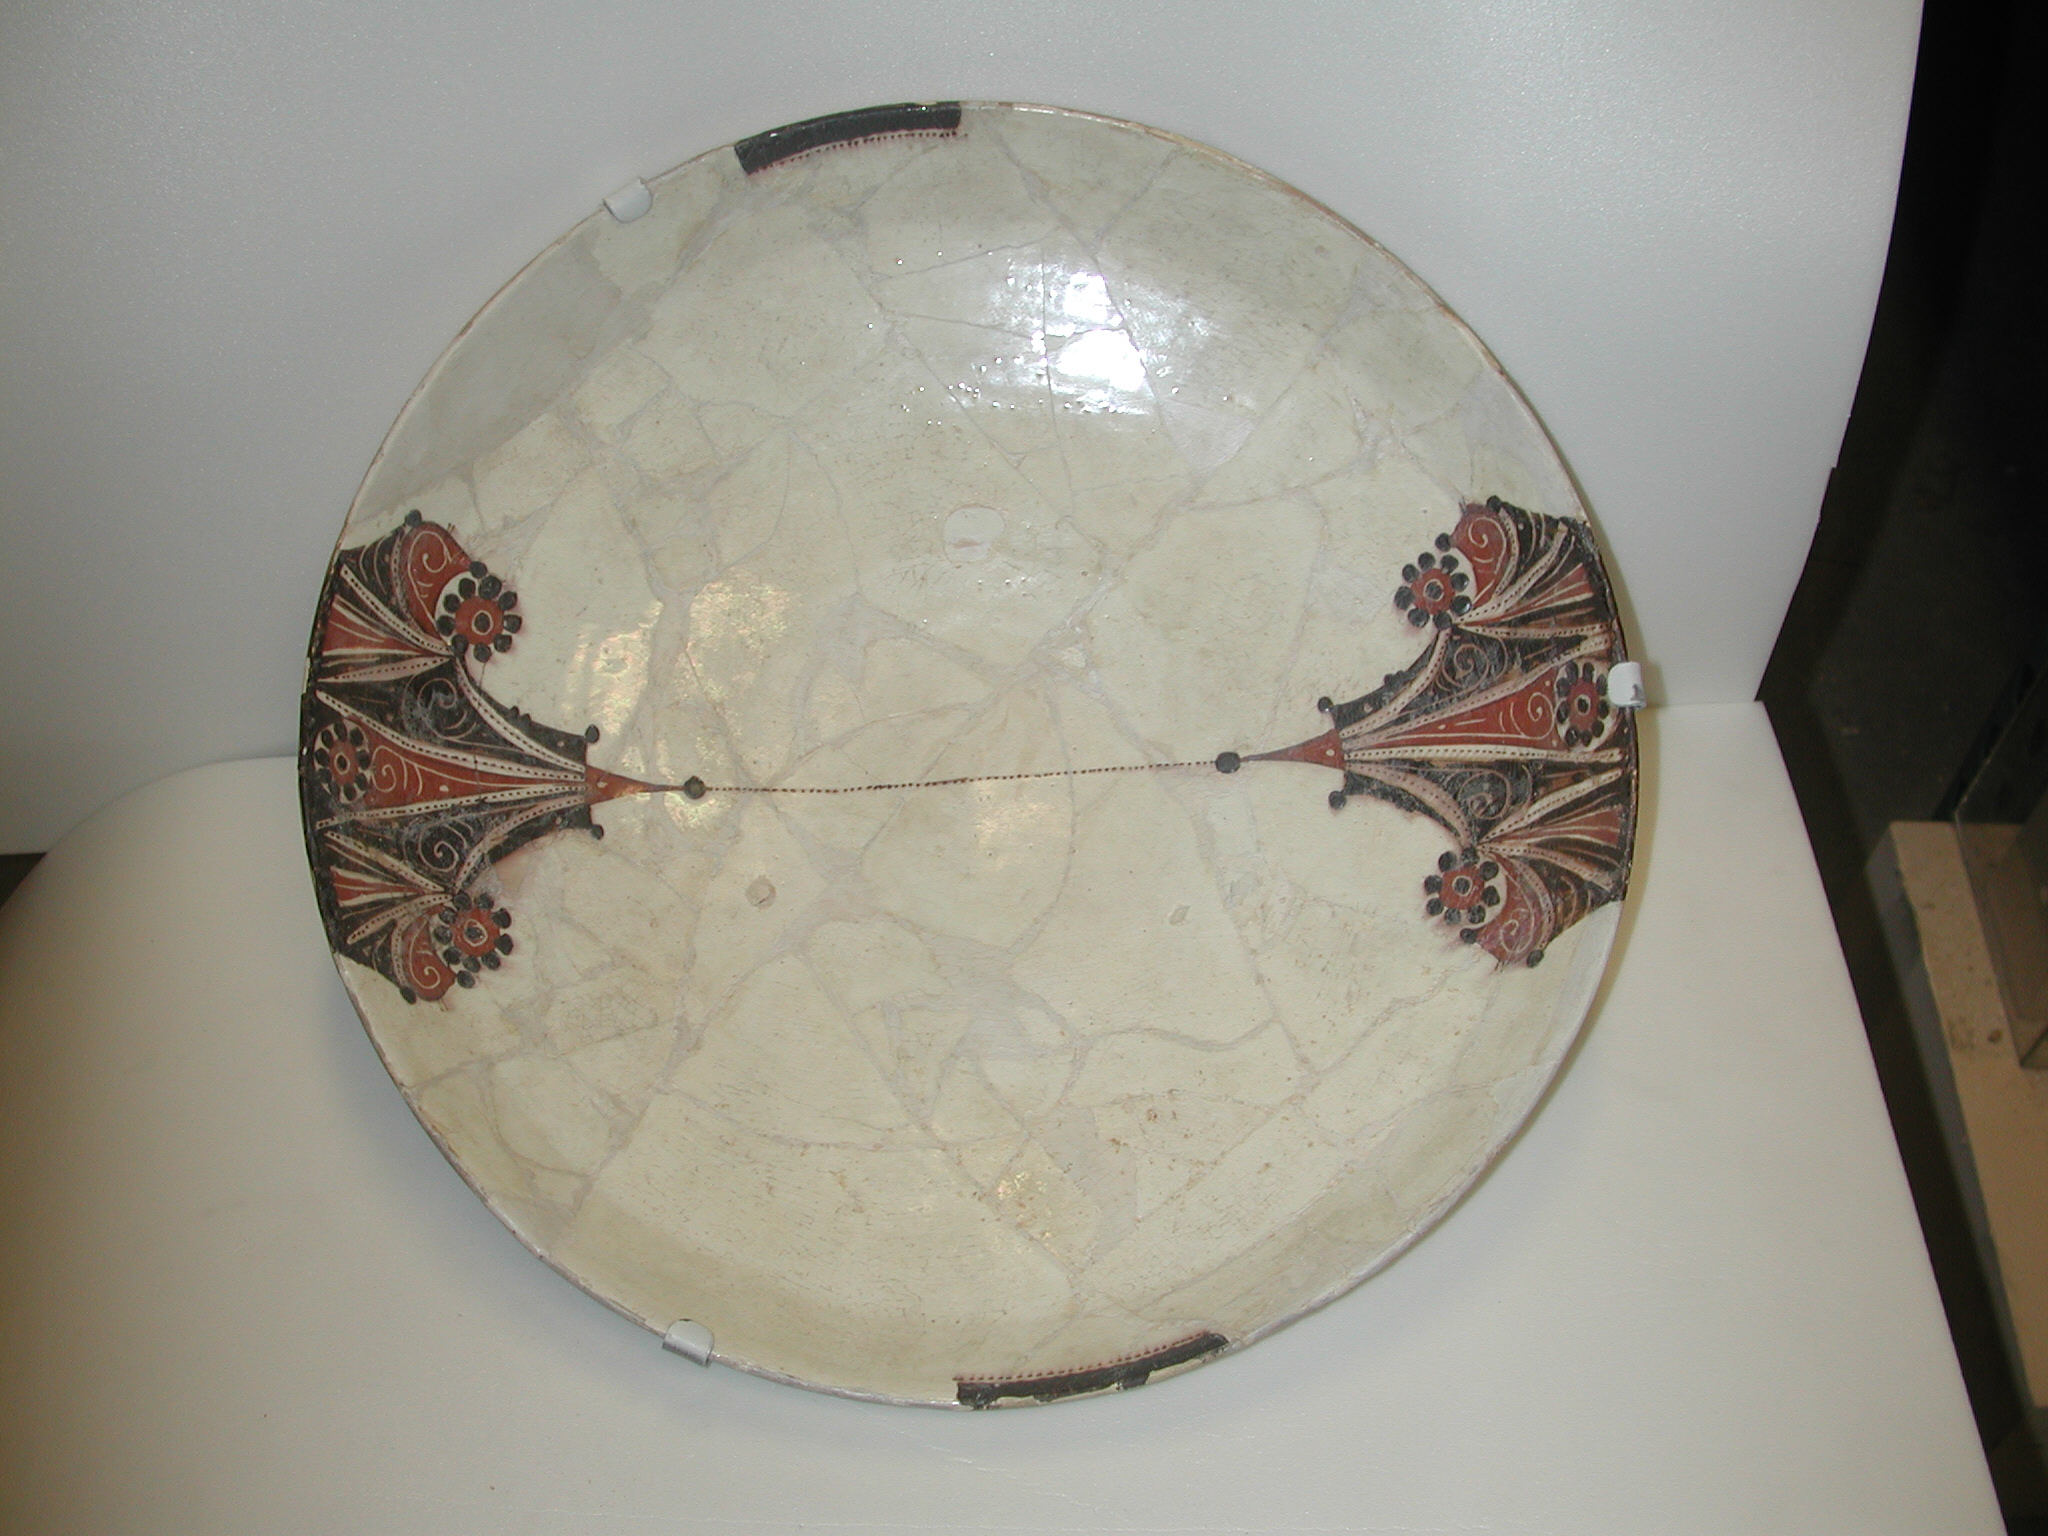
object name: bowl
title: Bowl with Red and Black Vegetal Motifs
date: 901-1000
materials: earthenware, glaze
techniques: polychrome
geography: uzbekistan